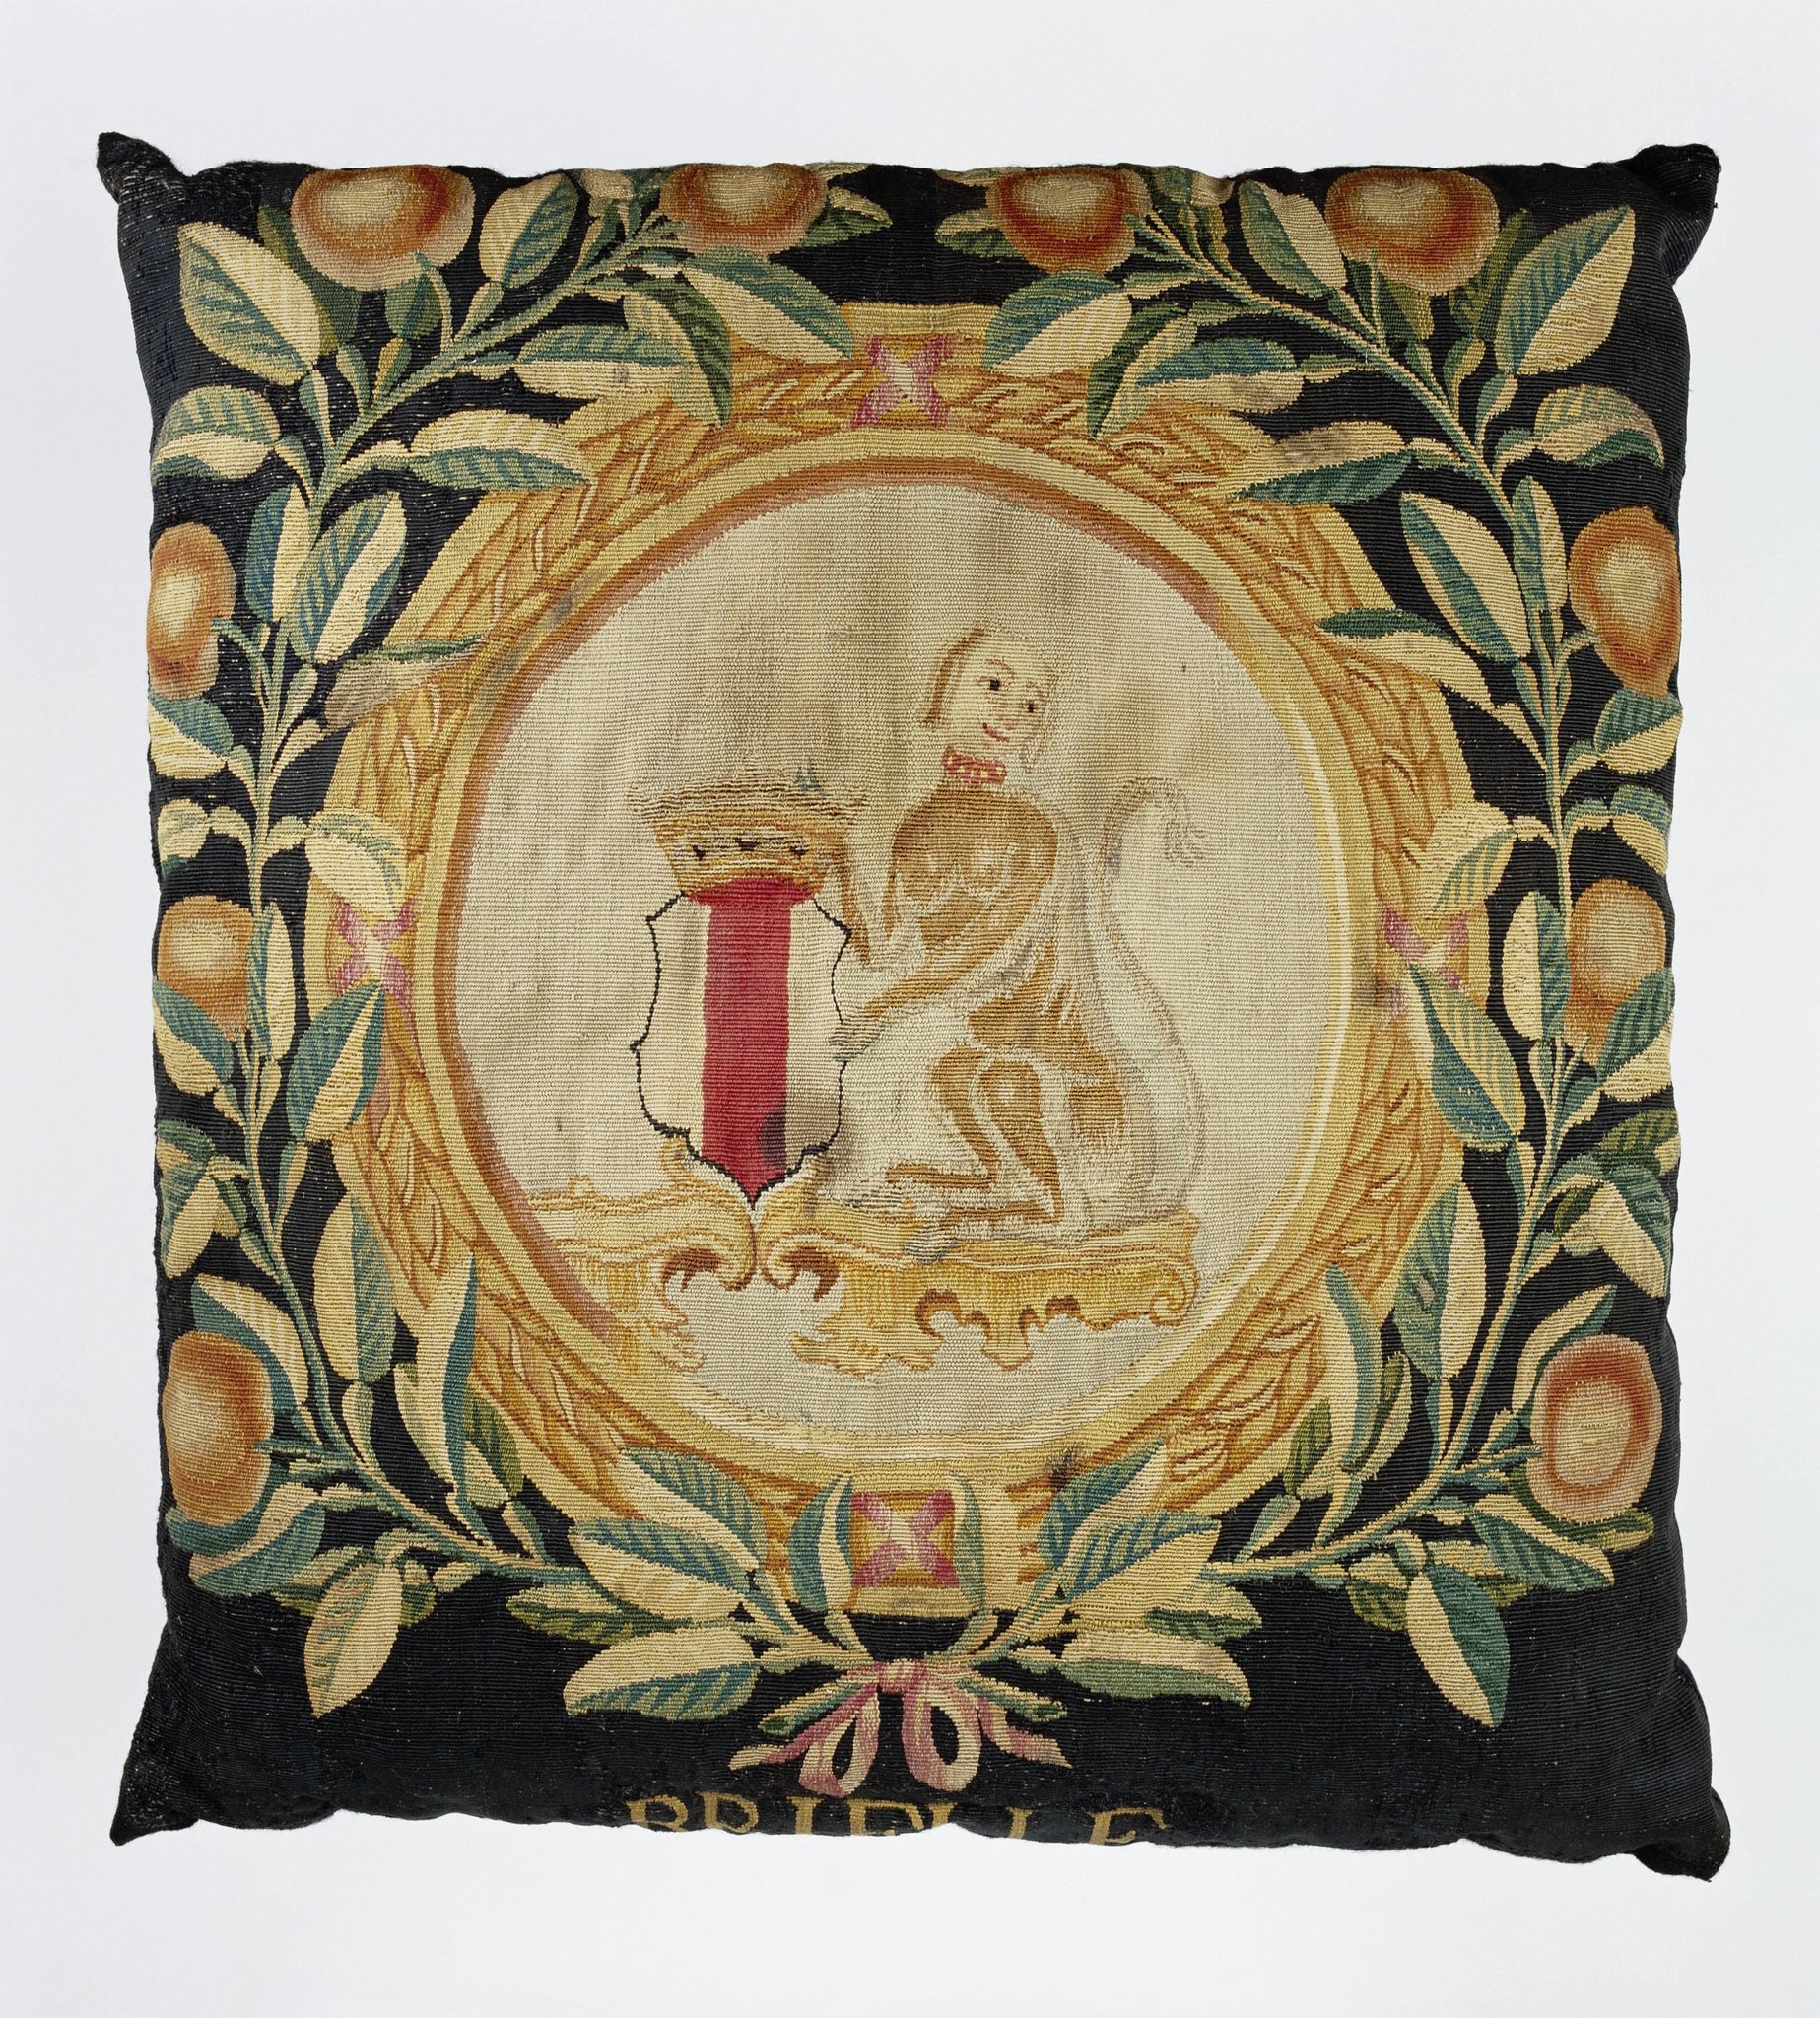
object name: magistratenkussen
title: Kussenovertrek met het stadswapen van Brielle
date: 1770-1790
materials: silk, wool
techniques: tapestry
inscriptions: inscription: ‘BRIELLE’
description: Magistratenkussen van tapijtweefsel met het wapen van Den Briel. Inscriptie "Brielle".